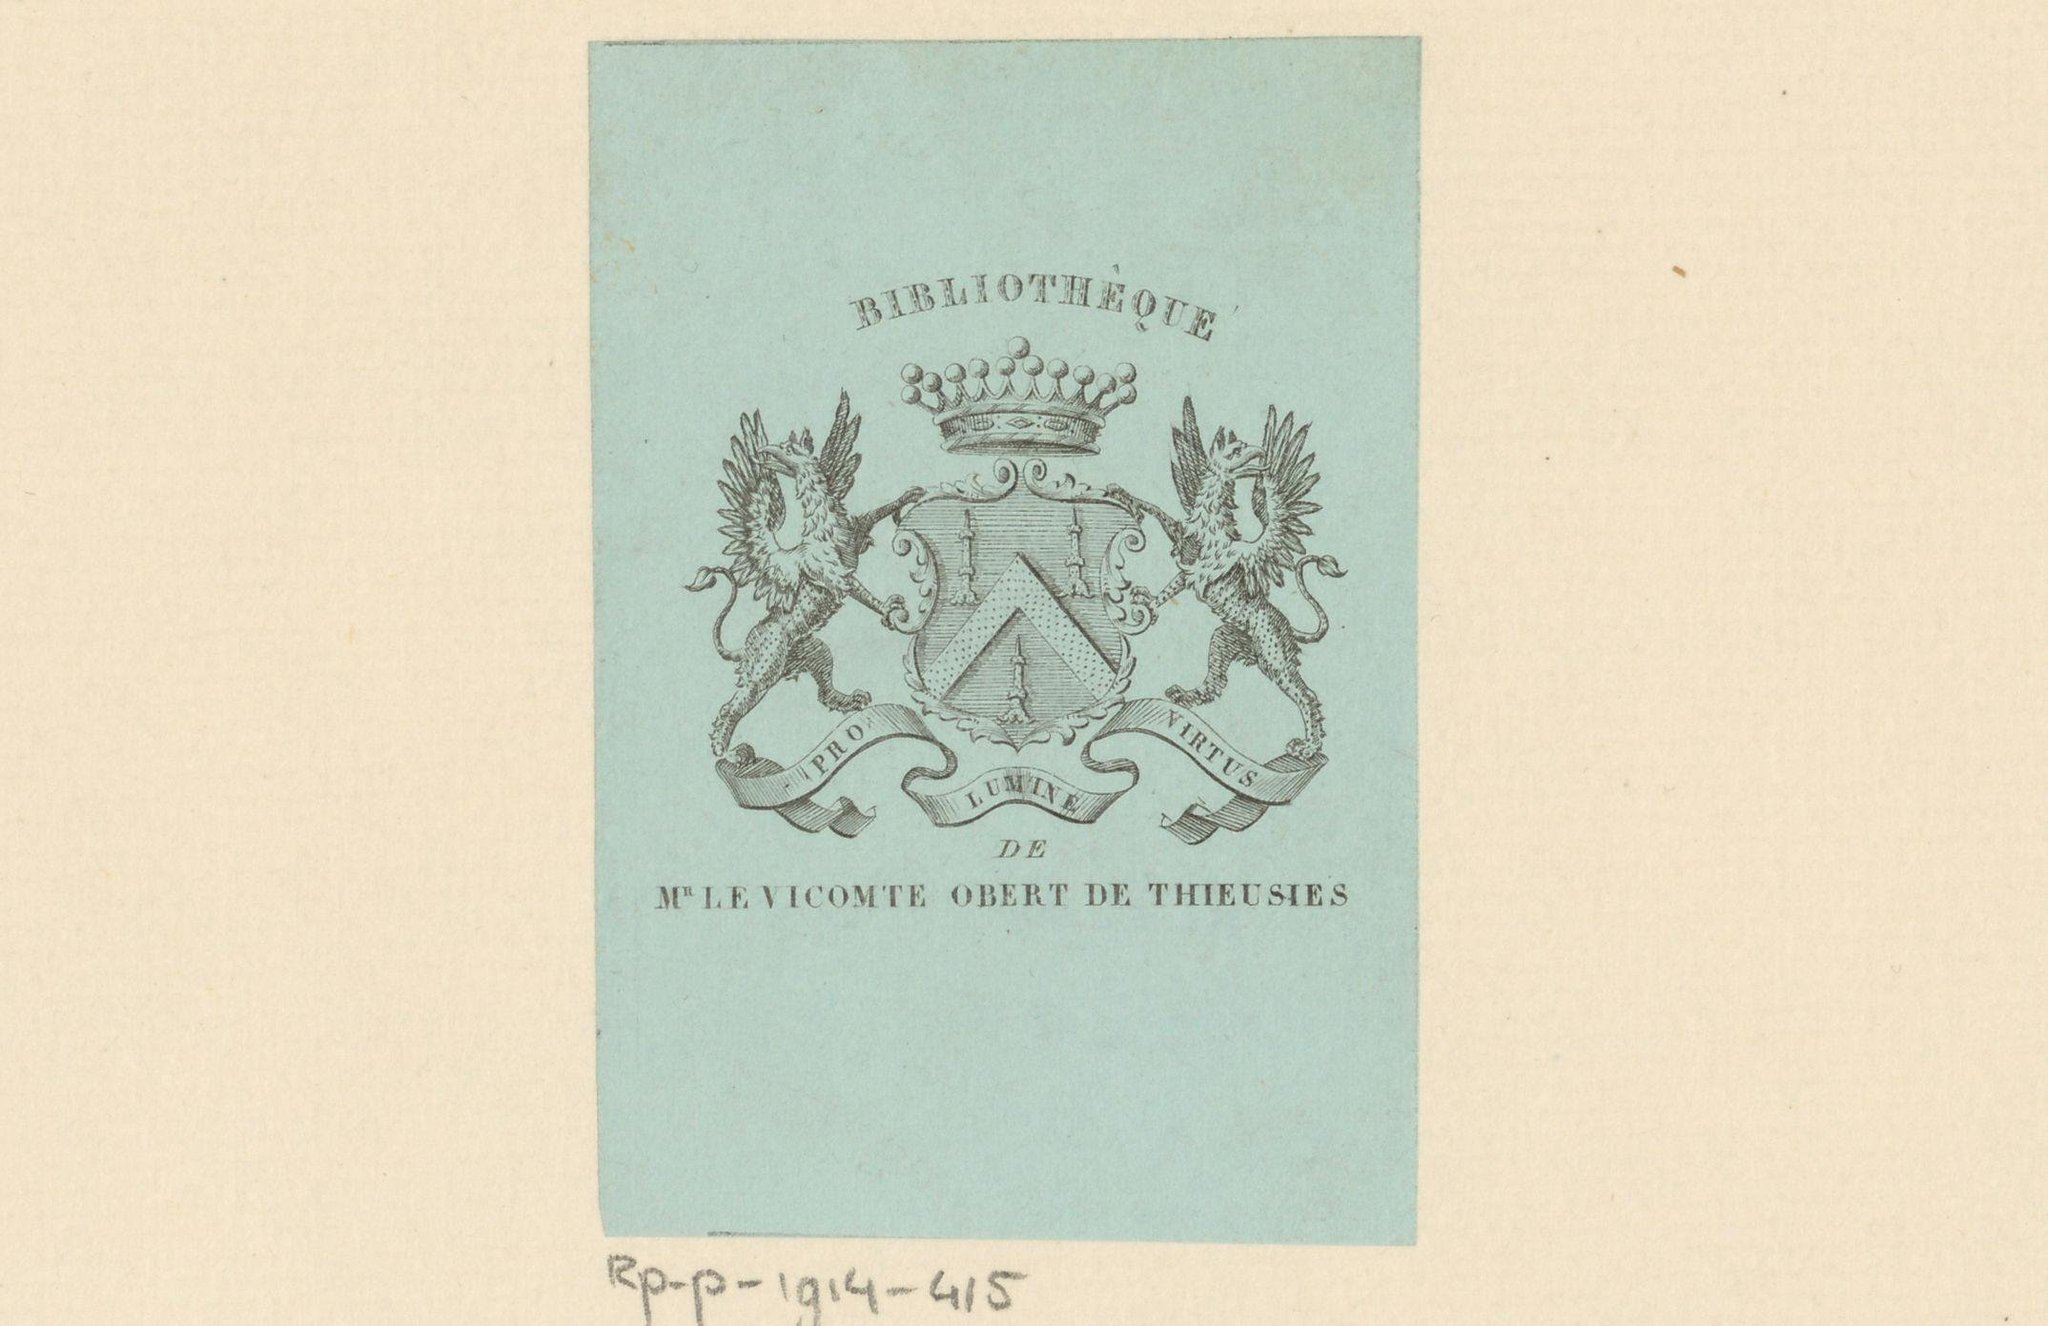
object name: bookplate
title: Pro lumine virtus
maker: Anonymous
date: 1800-1899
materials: paper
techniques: engraving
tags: armorial bearing, heraldry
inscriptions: collector's mark: Lugt 2760, collector's mark: Lugt 2233